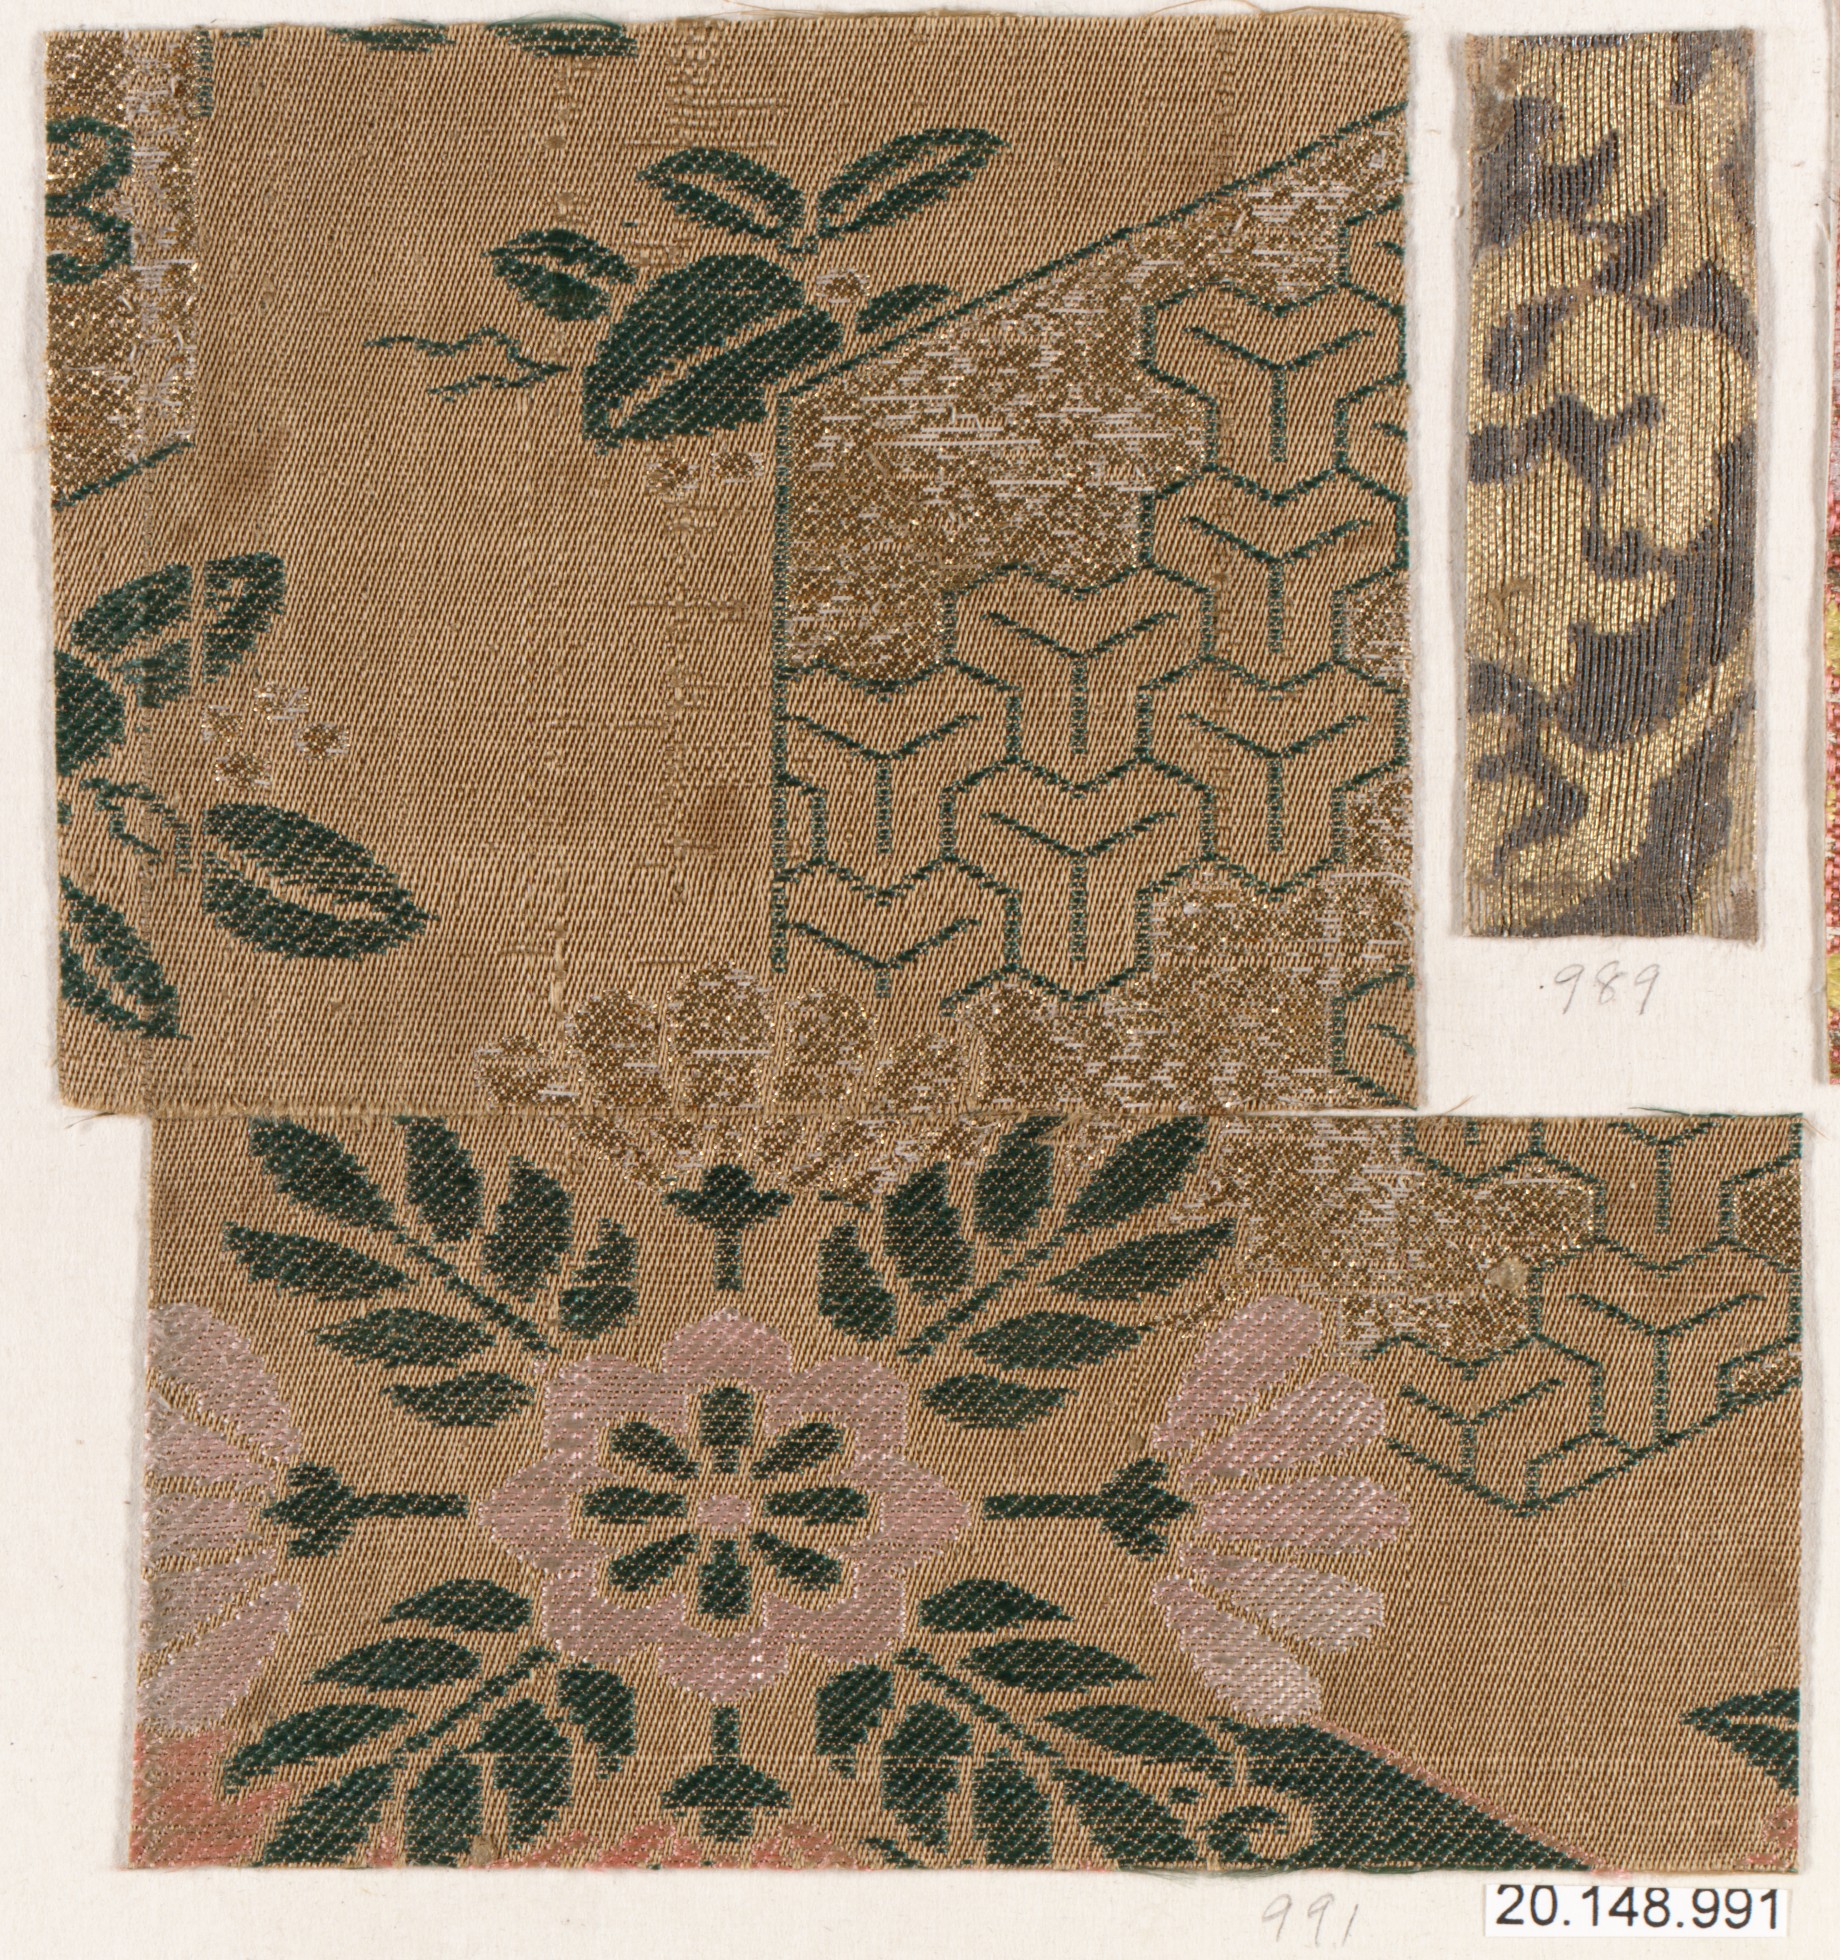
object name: piece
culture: japanese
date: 1601-1700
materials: silk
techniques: compound weave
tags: flowers,leaves